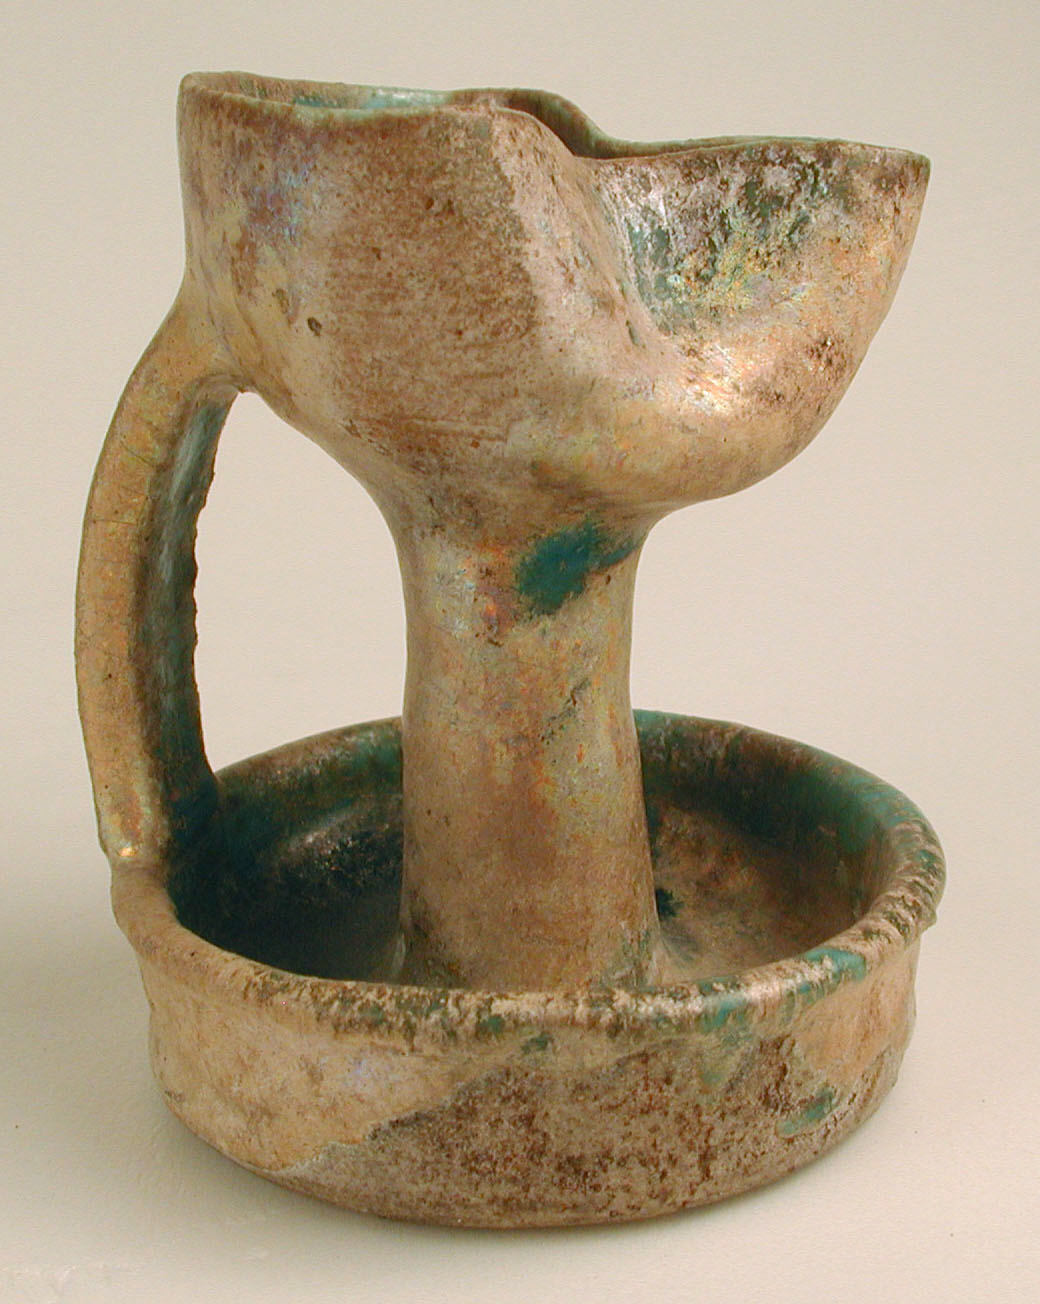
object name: lamp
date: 1101-1200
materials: stonepaste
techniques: glazing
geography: iran